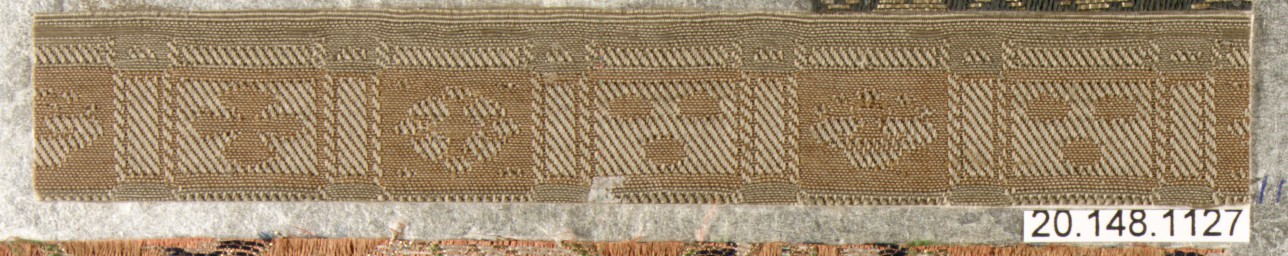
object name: piece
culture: japanese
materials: silk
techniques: compound weave